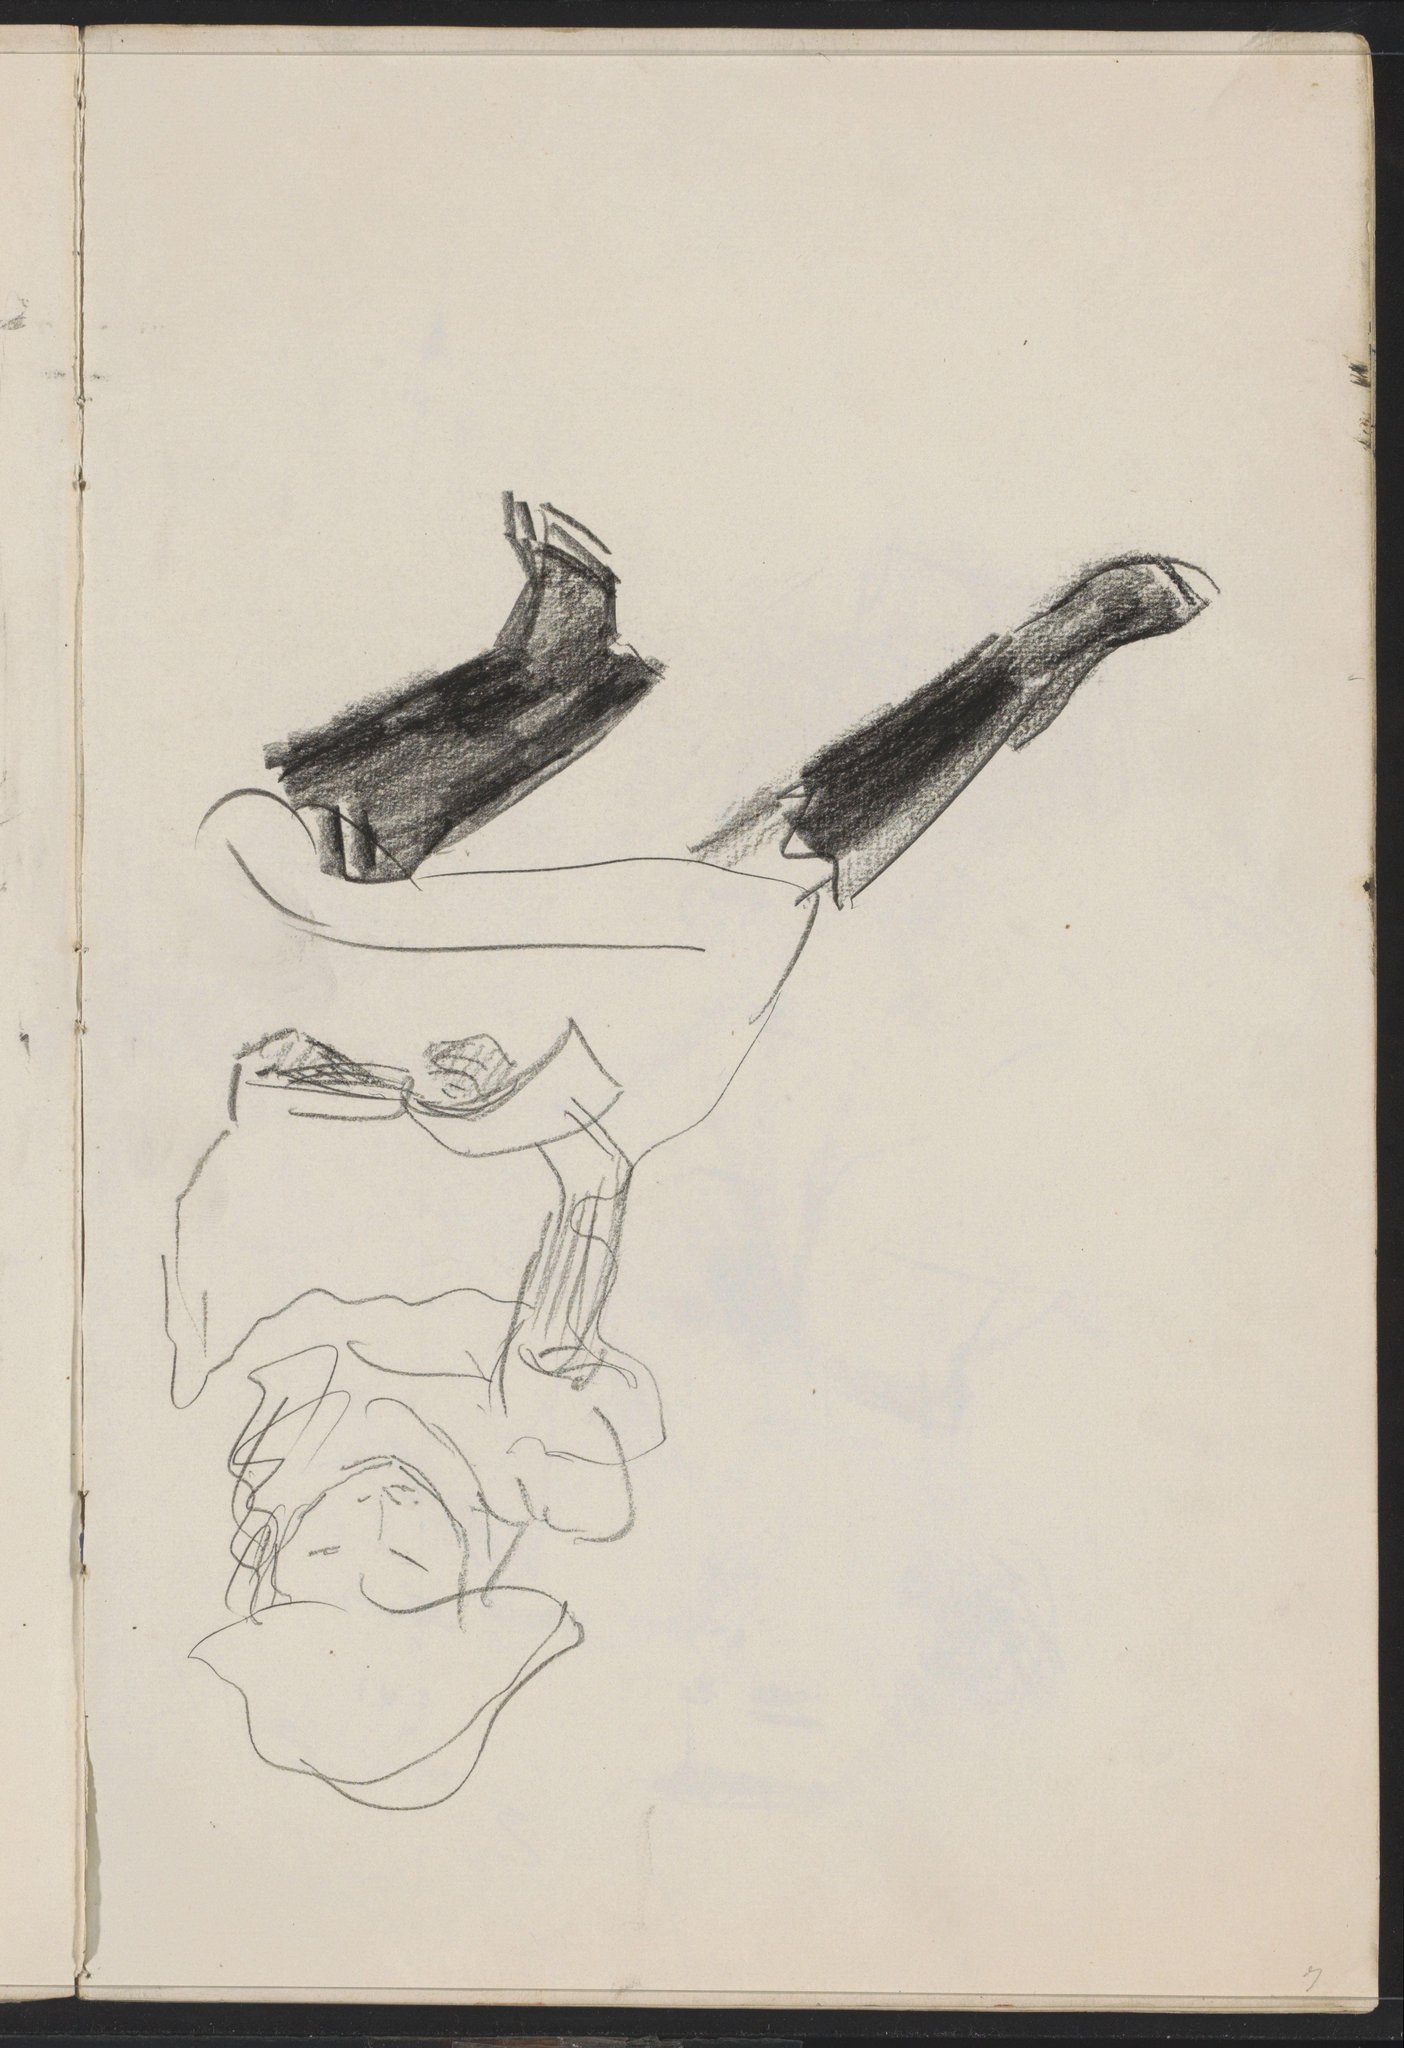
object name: sketchbook leaf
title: Lezend meisje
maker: isaac israels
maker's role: draughtsman, painter, print maker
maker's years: 1865-1934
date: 1875-1934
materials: chalk, paper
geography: the hague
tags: girl (child between toddler and youth) (+ sitting), reading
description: Blad 7 recto uit schetsboek LXIX met 25 bladen.